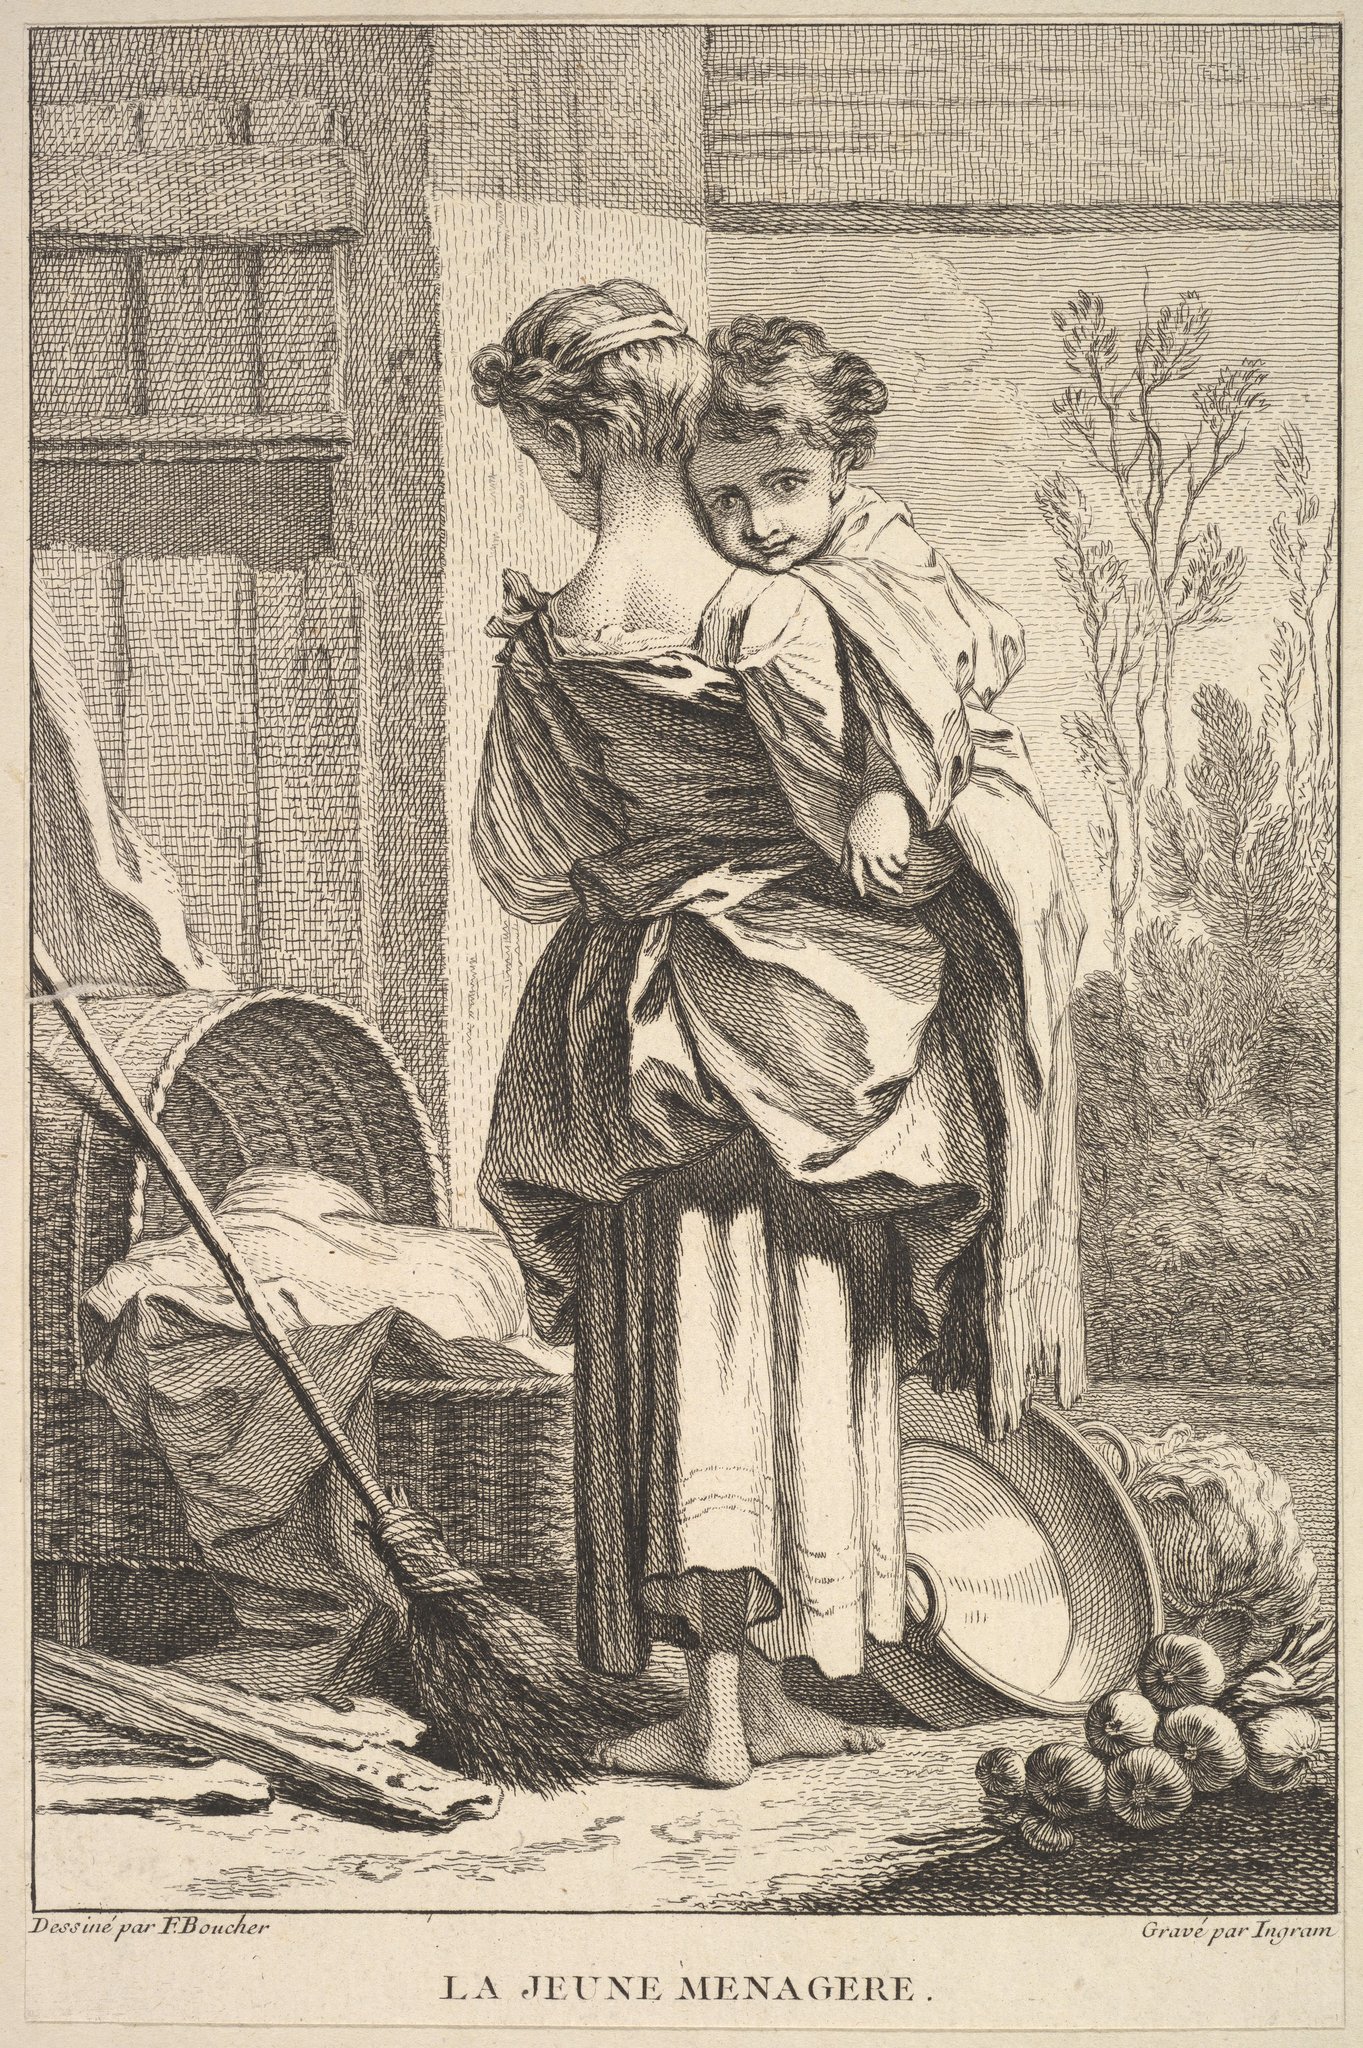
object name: print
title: The Young Housekeeper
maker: john ingram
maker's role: artist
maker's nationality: british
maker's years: 1721-1759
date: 1741-1763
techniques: engraving, etching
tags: children,women,servants